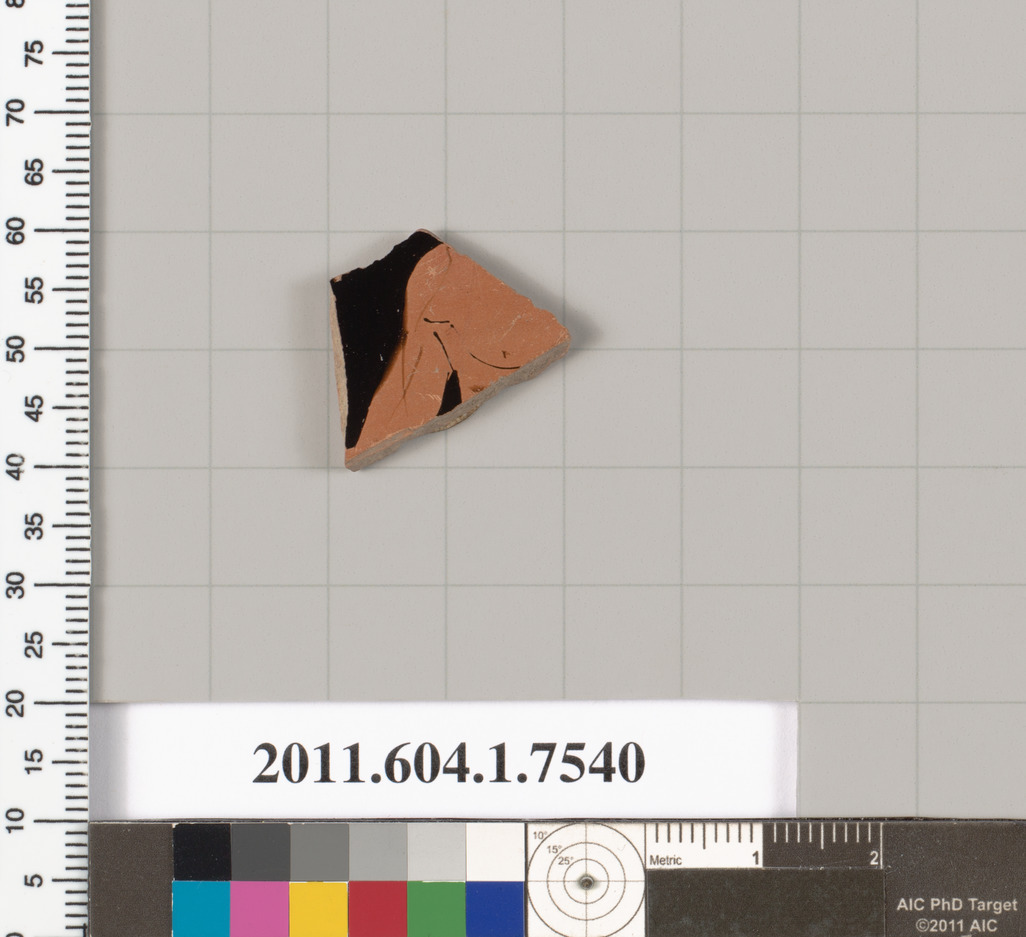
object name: kylix fragment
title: Terracotta fragment of a kylix (drinking cup)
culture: greek, attic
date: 460-450 BCE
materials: terracotta